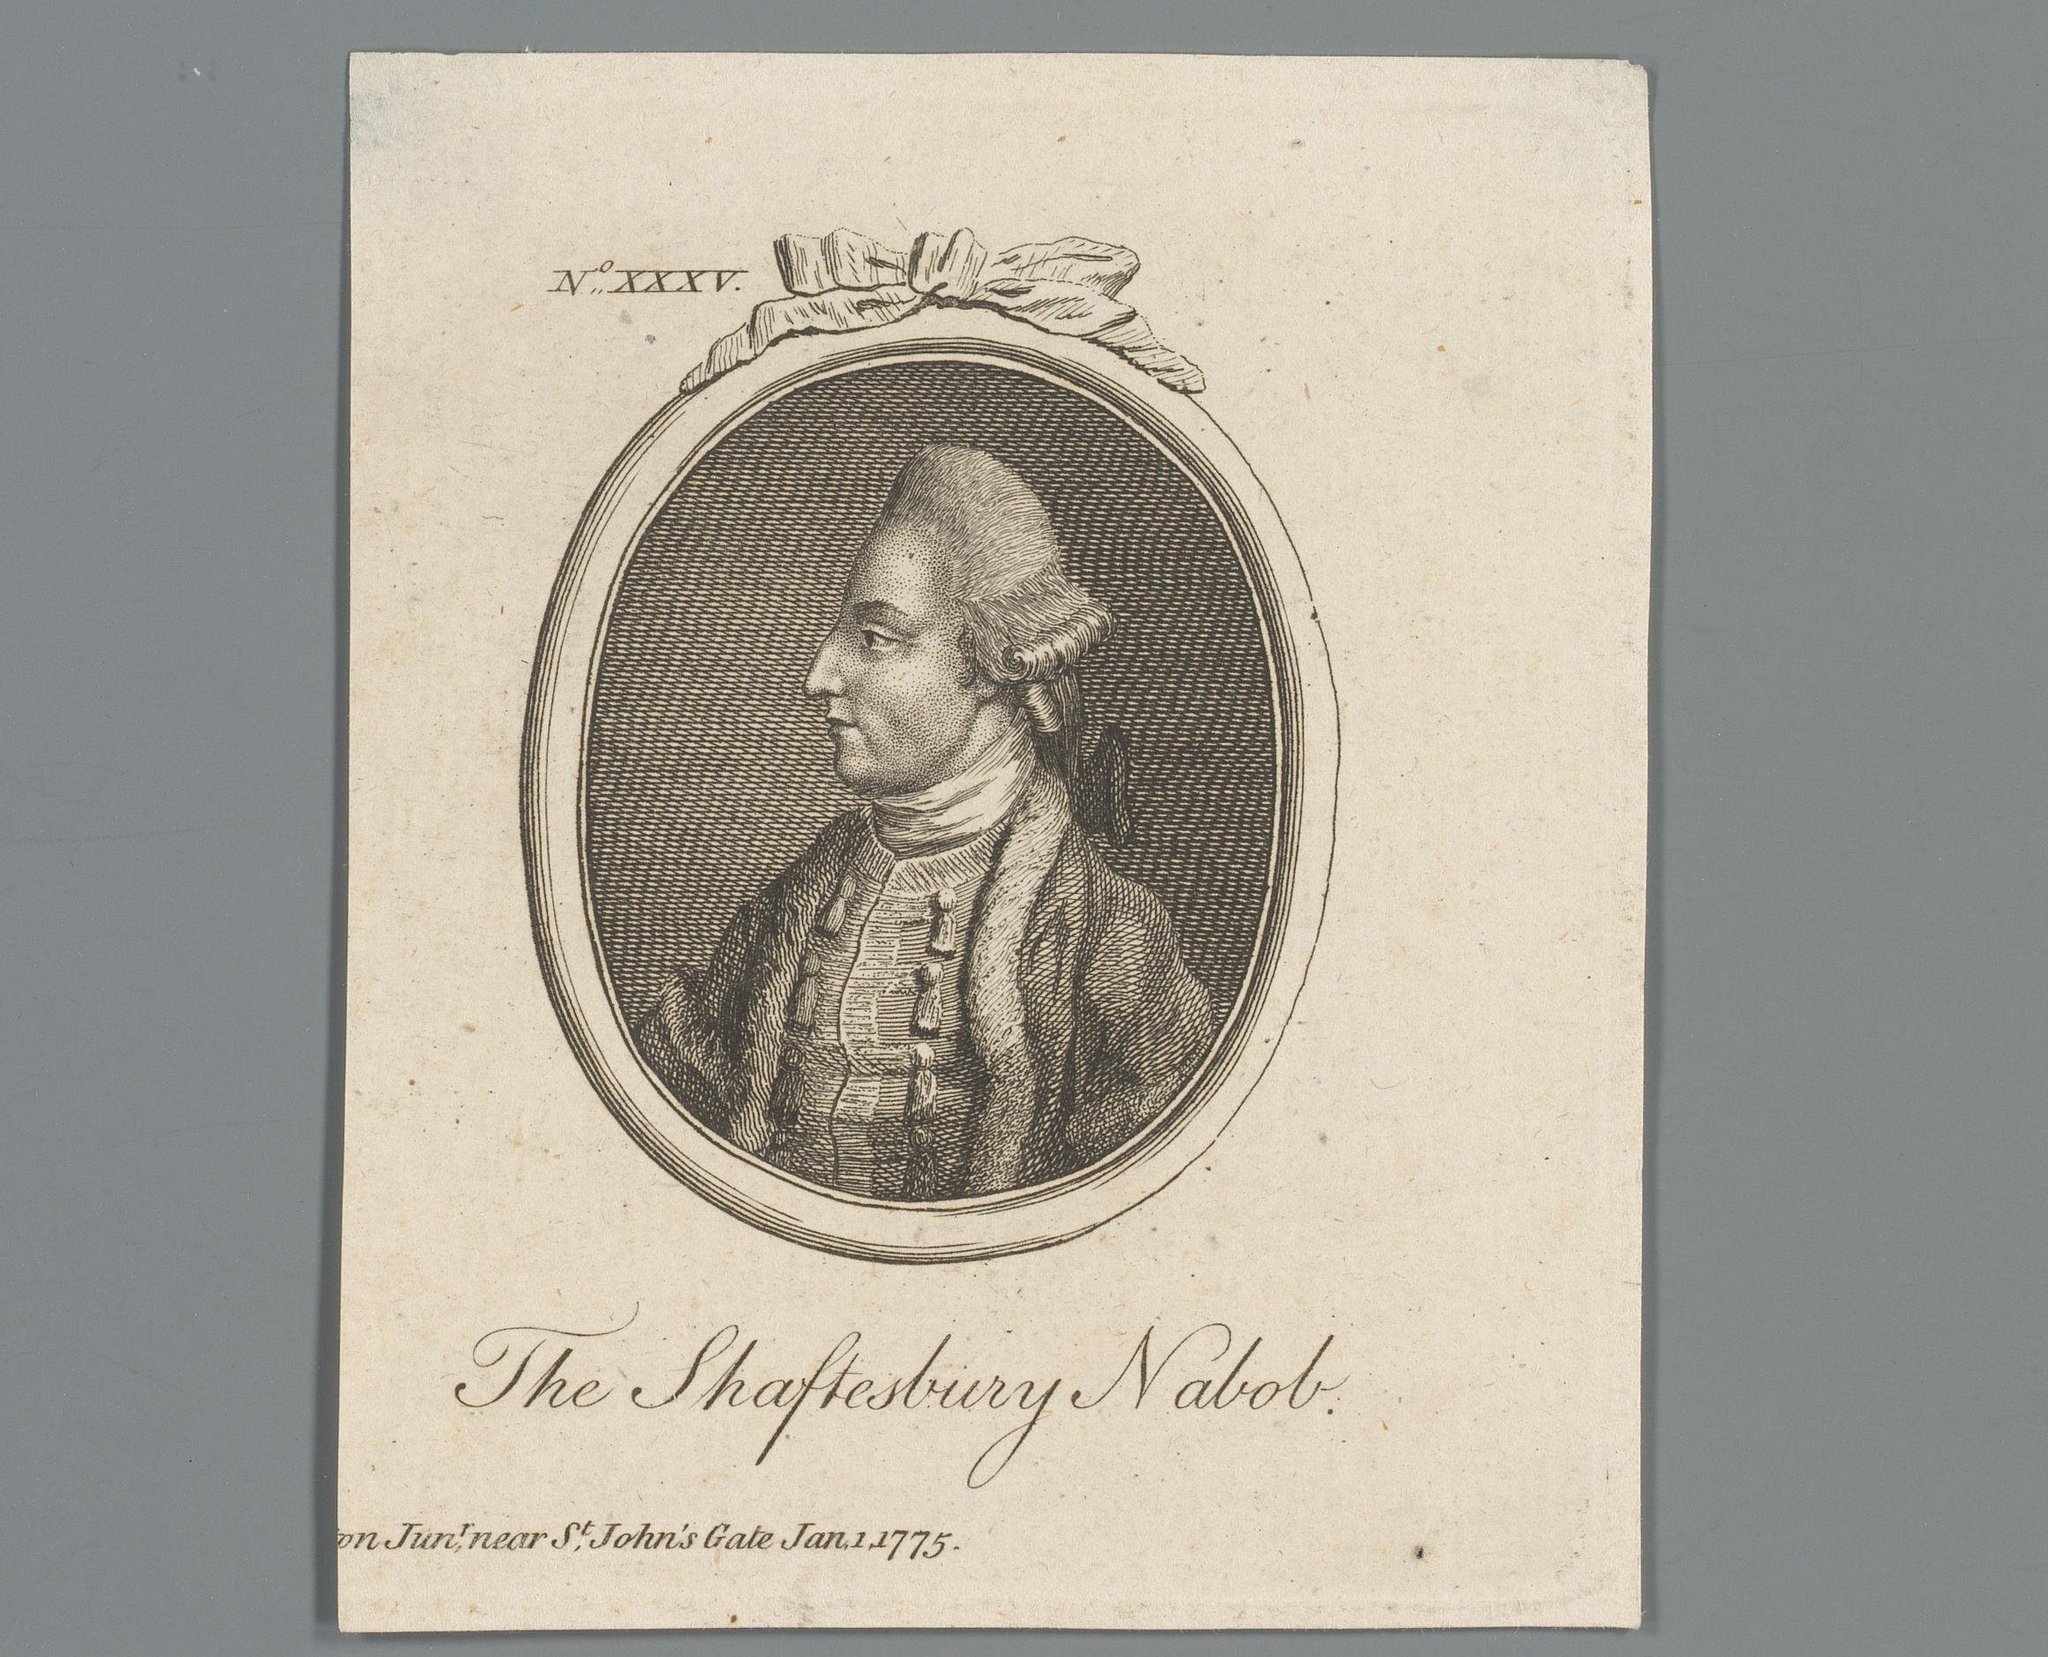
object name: print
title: The Shaftesbury Nabob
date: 1775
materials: paper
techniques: etching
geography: london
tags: wig, historical persons not known by name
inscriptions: collector's mark: Lugt 2228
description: Prent waarschijnlijk uit: Town and Country Magazine 7 (1775), januari 1775.